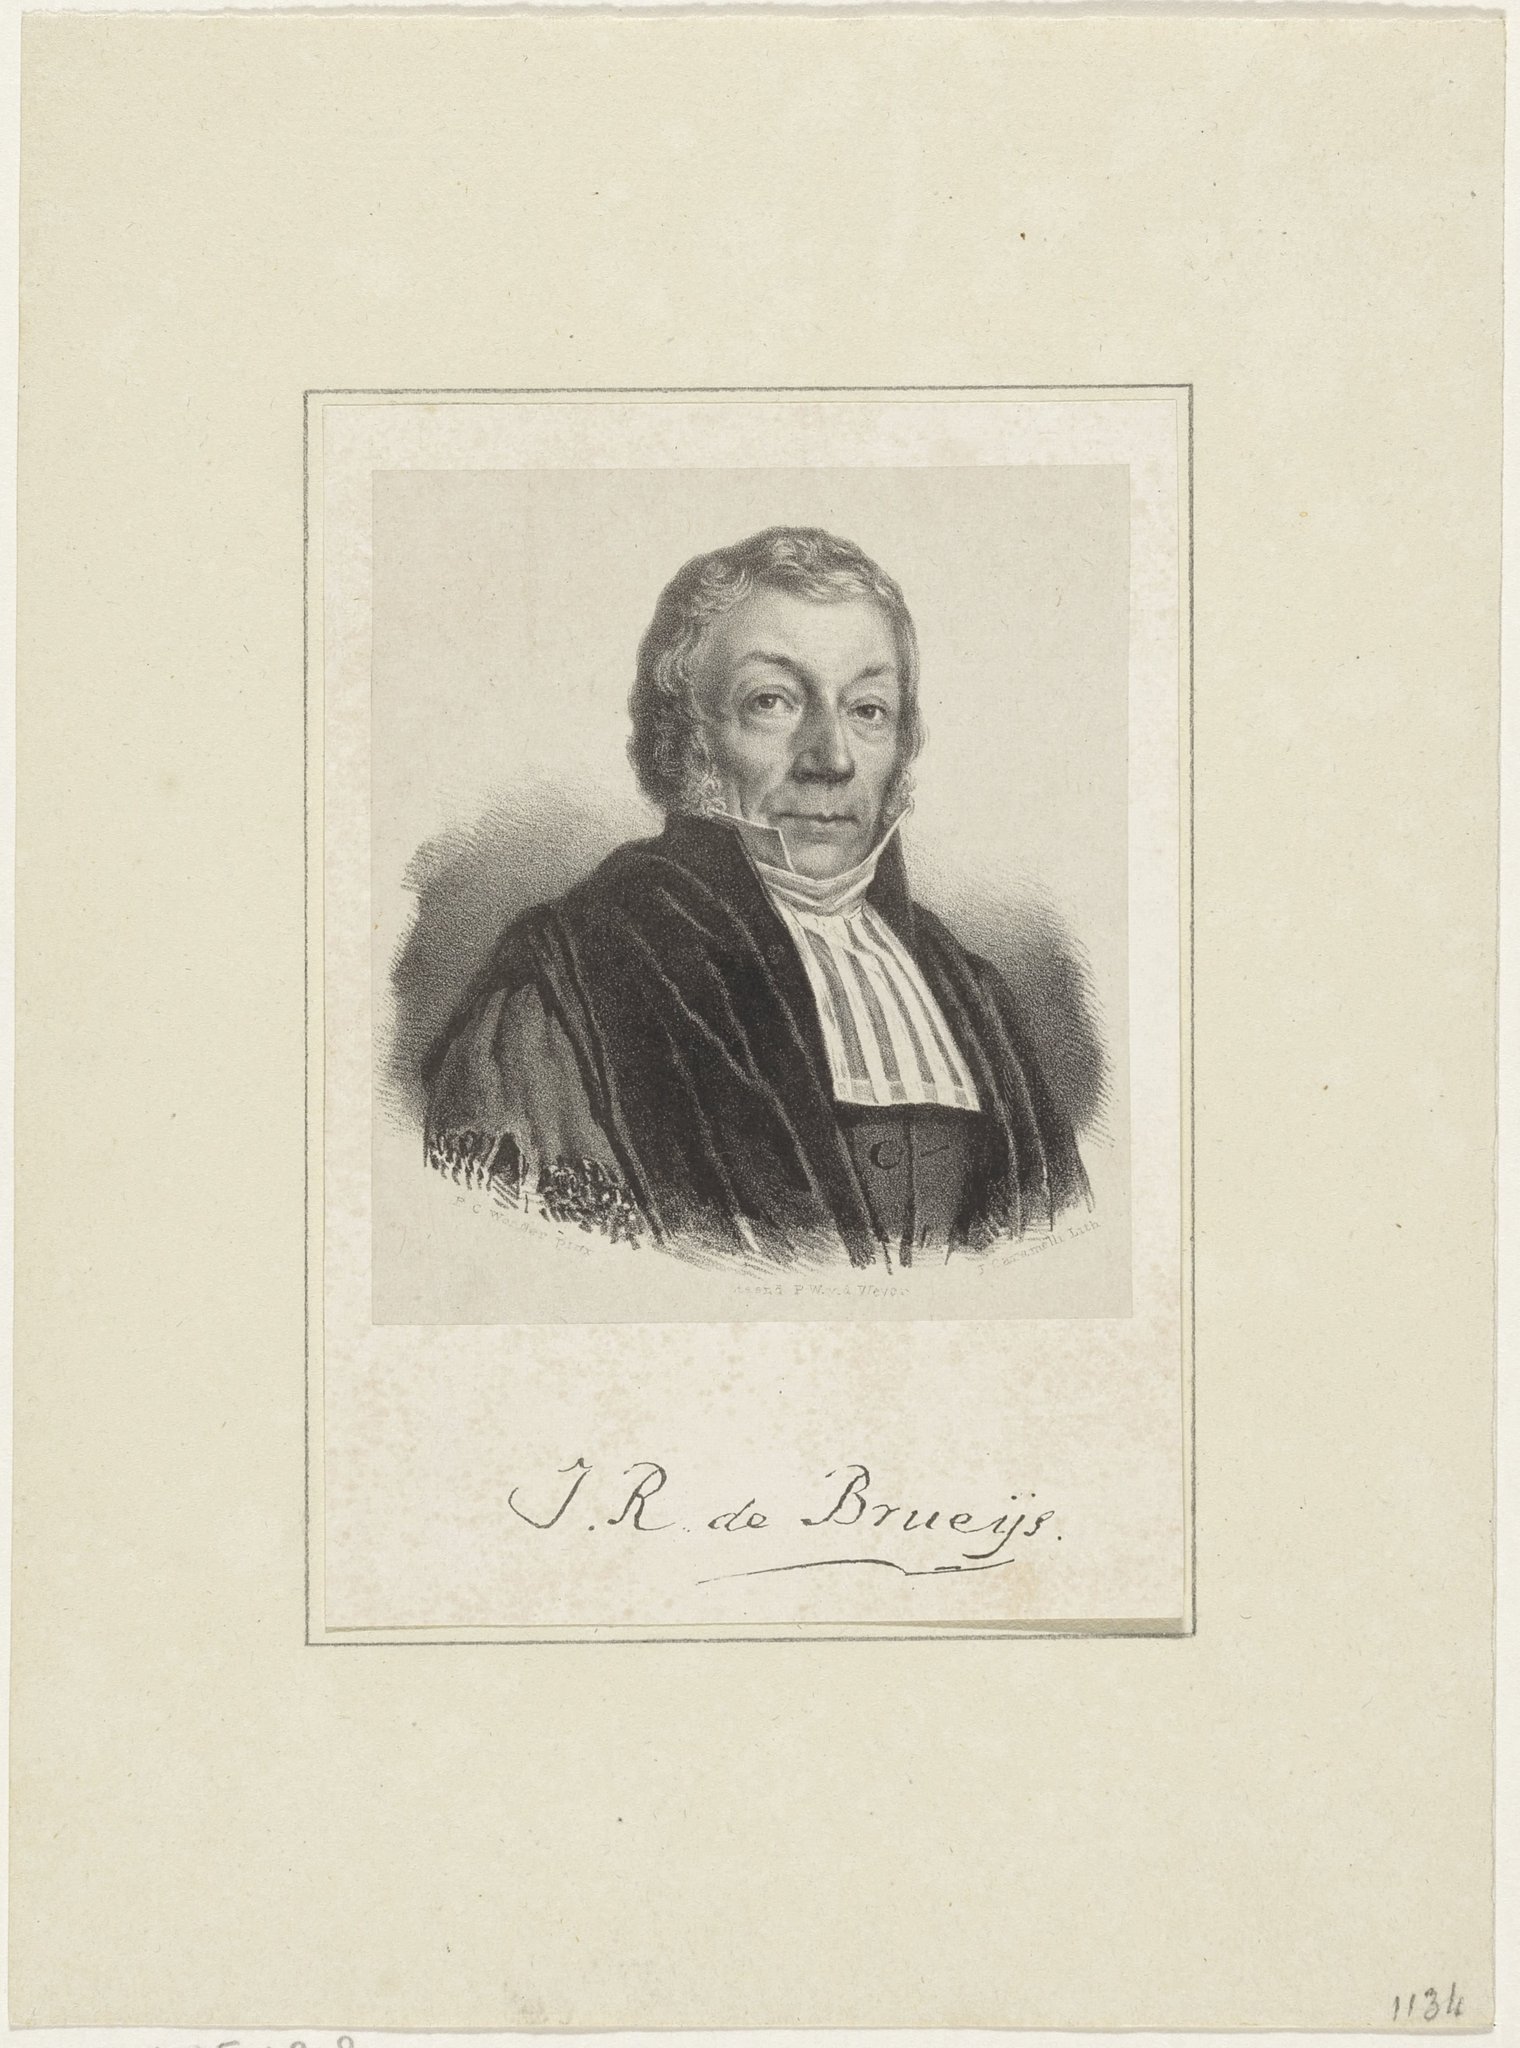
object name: print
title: Portret van J.R. de Brueijs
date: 1826-1881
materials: paper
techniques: lithograph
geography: amsterdam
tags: historical persons (+ (full) bust portrait)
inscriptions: collector's mark: Lugt 2228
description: De geportretteerde draagt een toga en een witte bef. Onder het portret zijn signatuur.